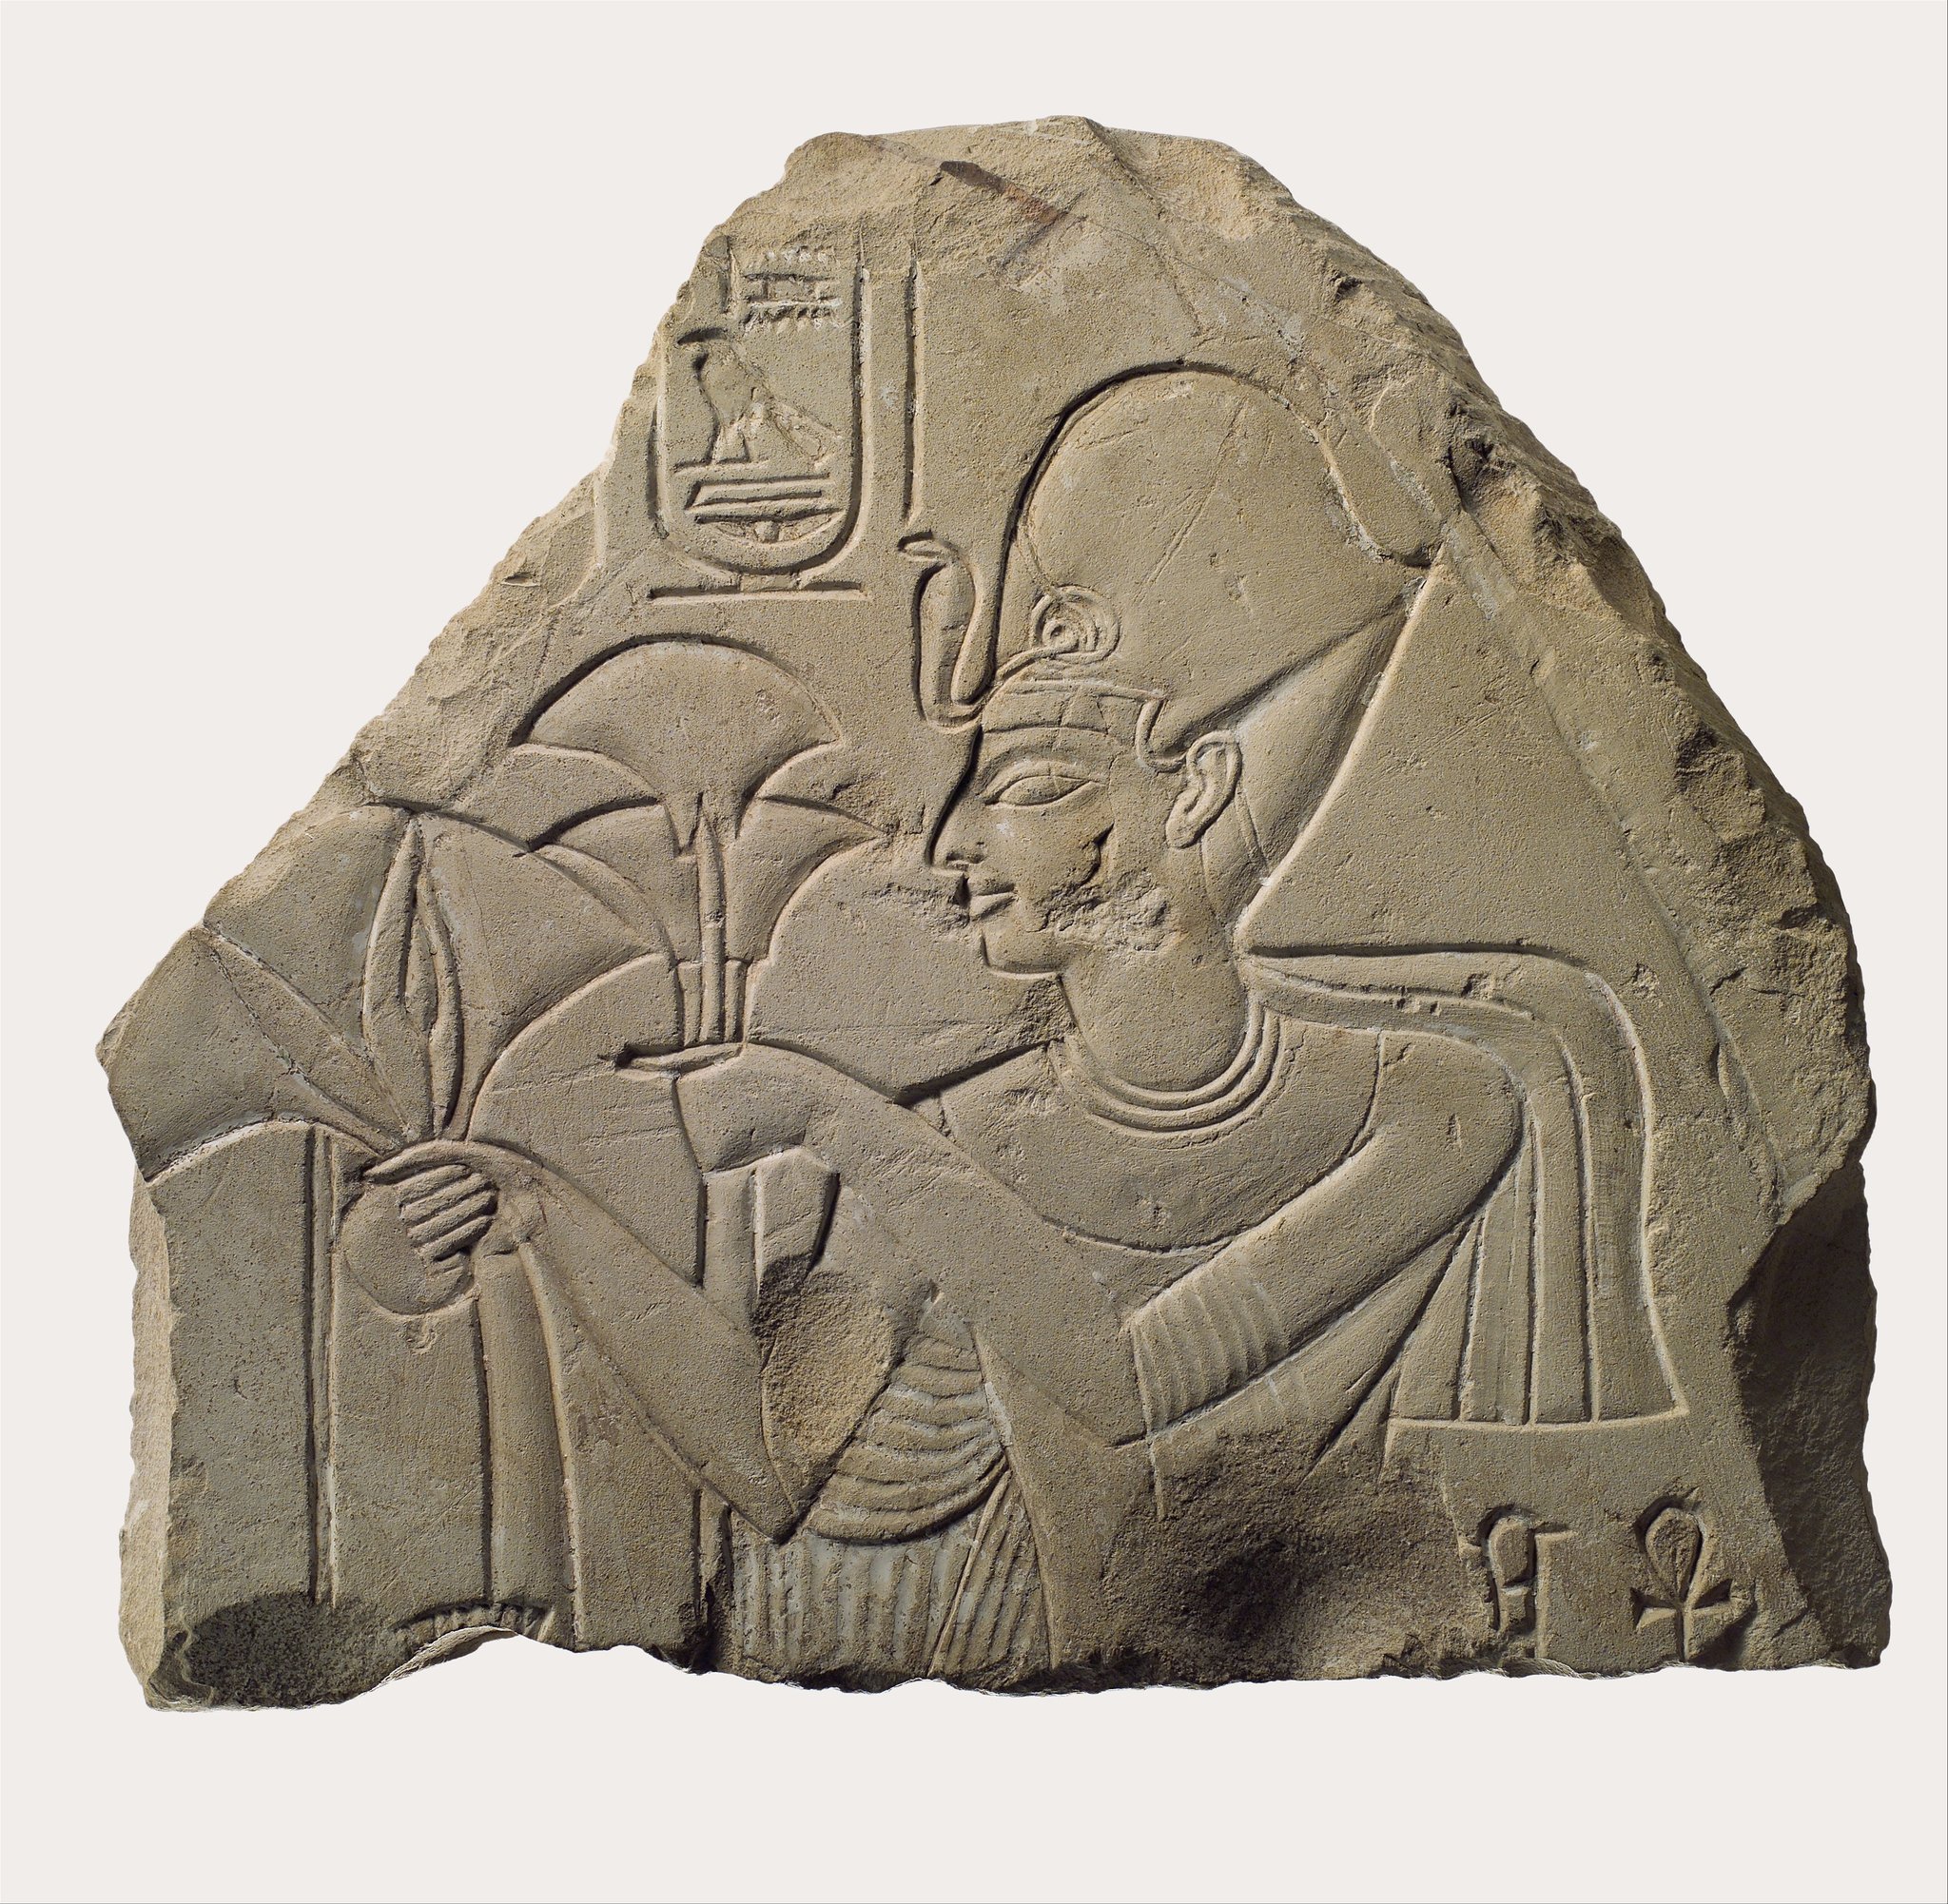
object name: relief, haremhab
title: Relief of Haremhab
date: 1323-1295 BCE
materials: limestone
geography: egypt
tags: kings